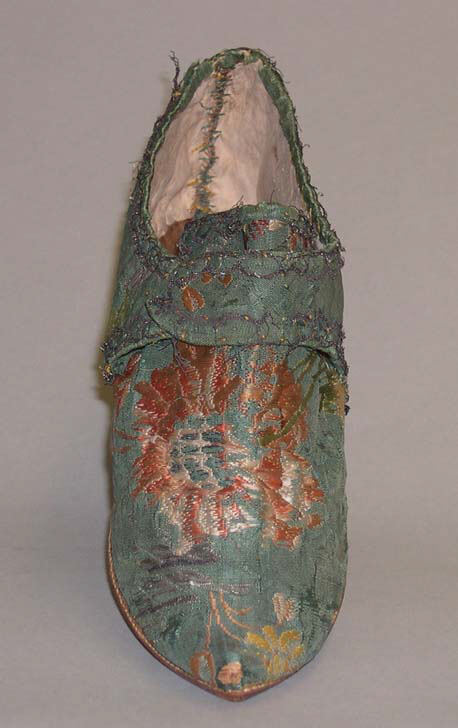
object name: shoe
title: Shoes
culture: french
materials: silk